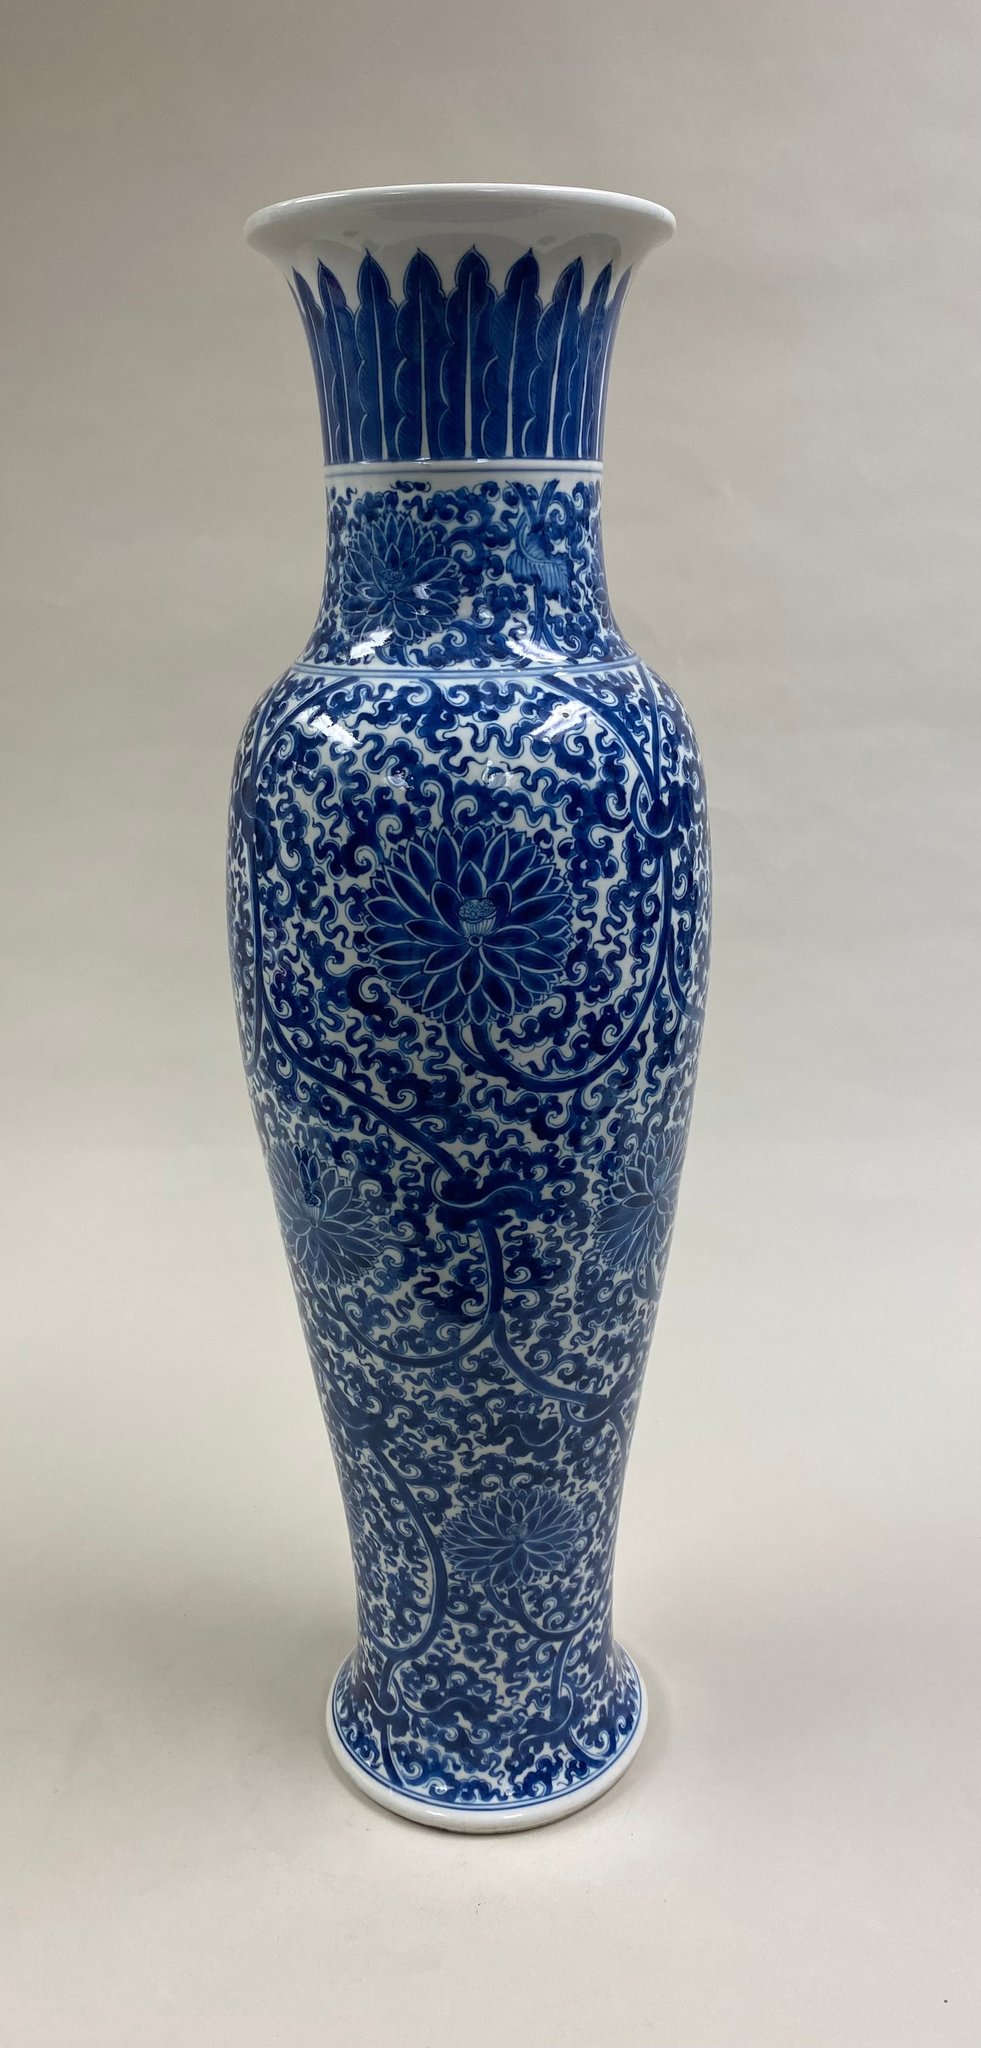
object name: vase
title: Vase with floral scrolls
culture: chinese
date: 1667-1733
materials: cobalt, porcelain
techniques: painting, underglaze